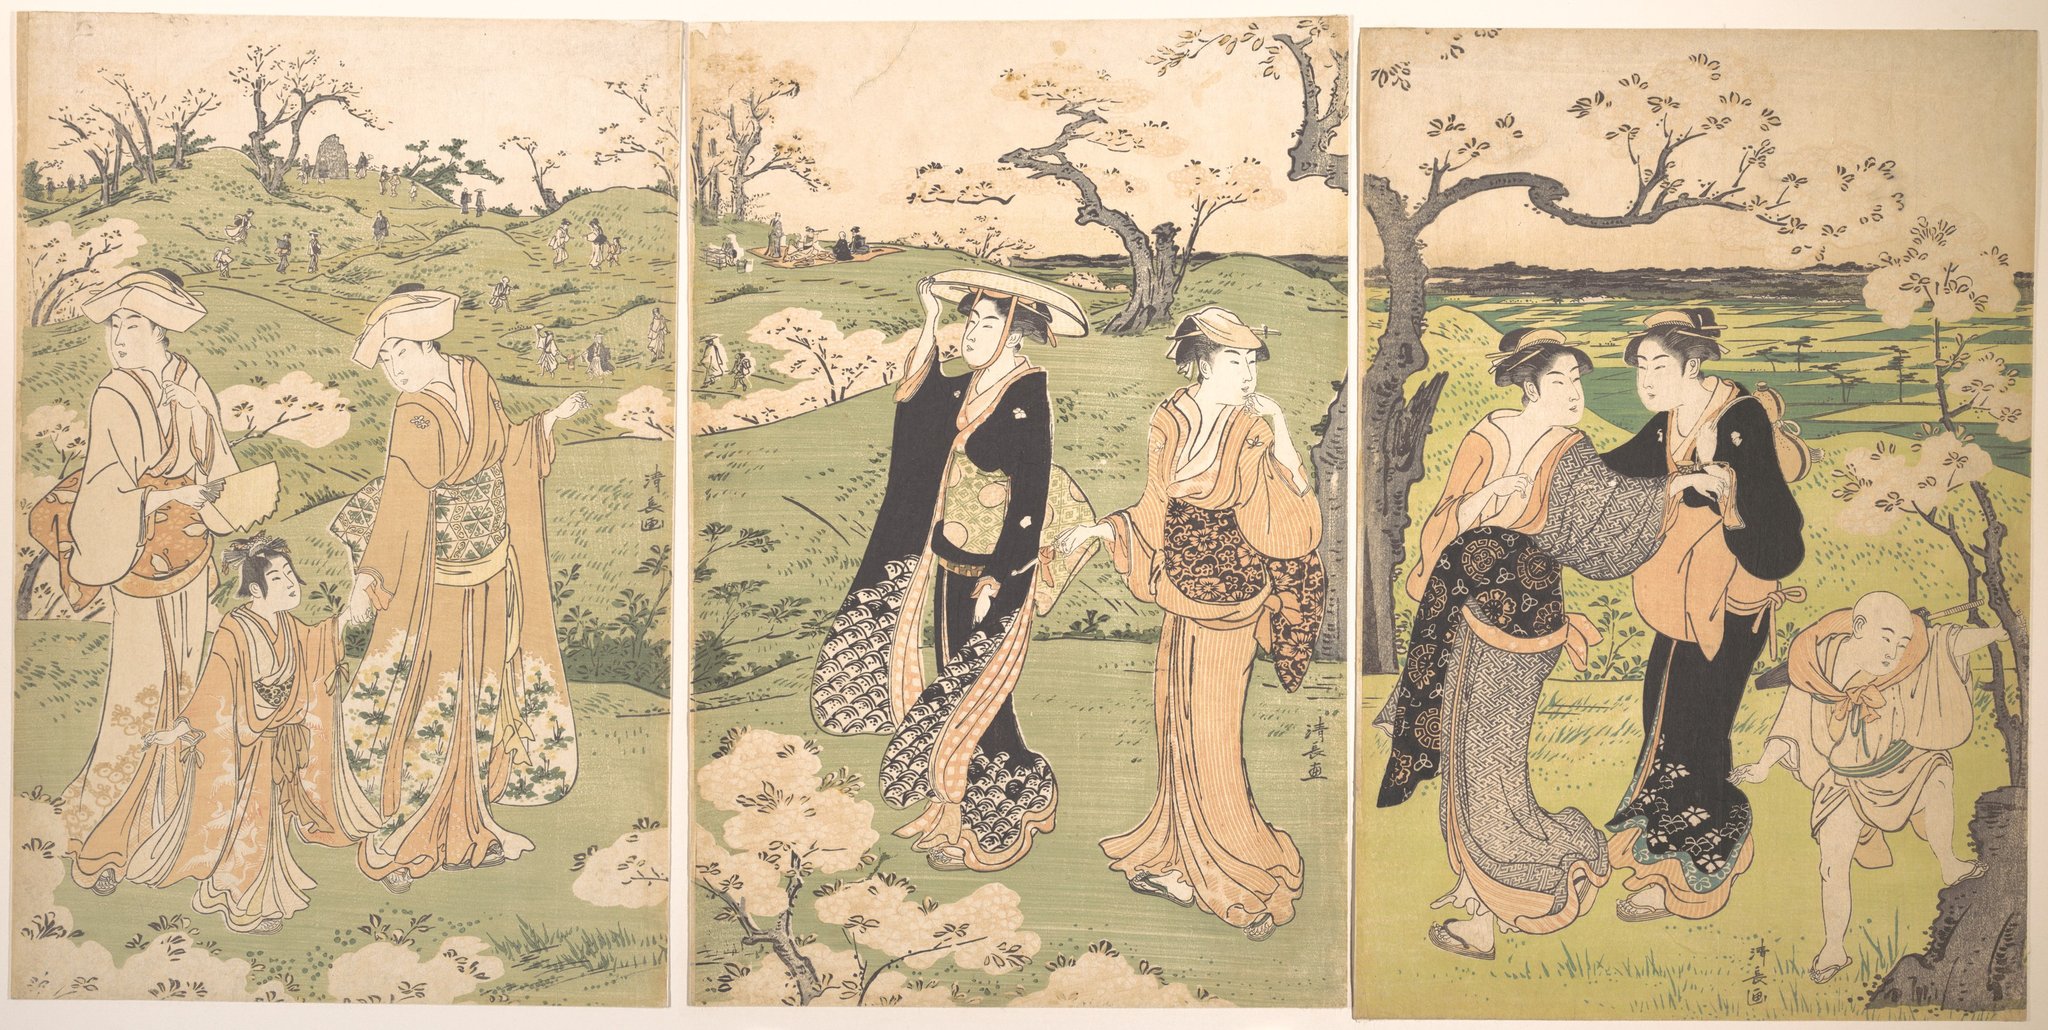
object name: print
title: Young Ladies Viewing Cherry–blossoms at Asukayama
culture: japanese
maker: torii kiyonaga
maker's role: artist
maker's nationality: japanese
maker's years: 1752-1815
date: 1742-1815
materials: ink, paper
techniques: woodblock print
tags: boys,girls,women,trees